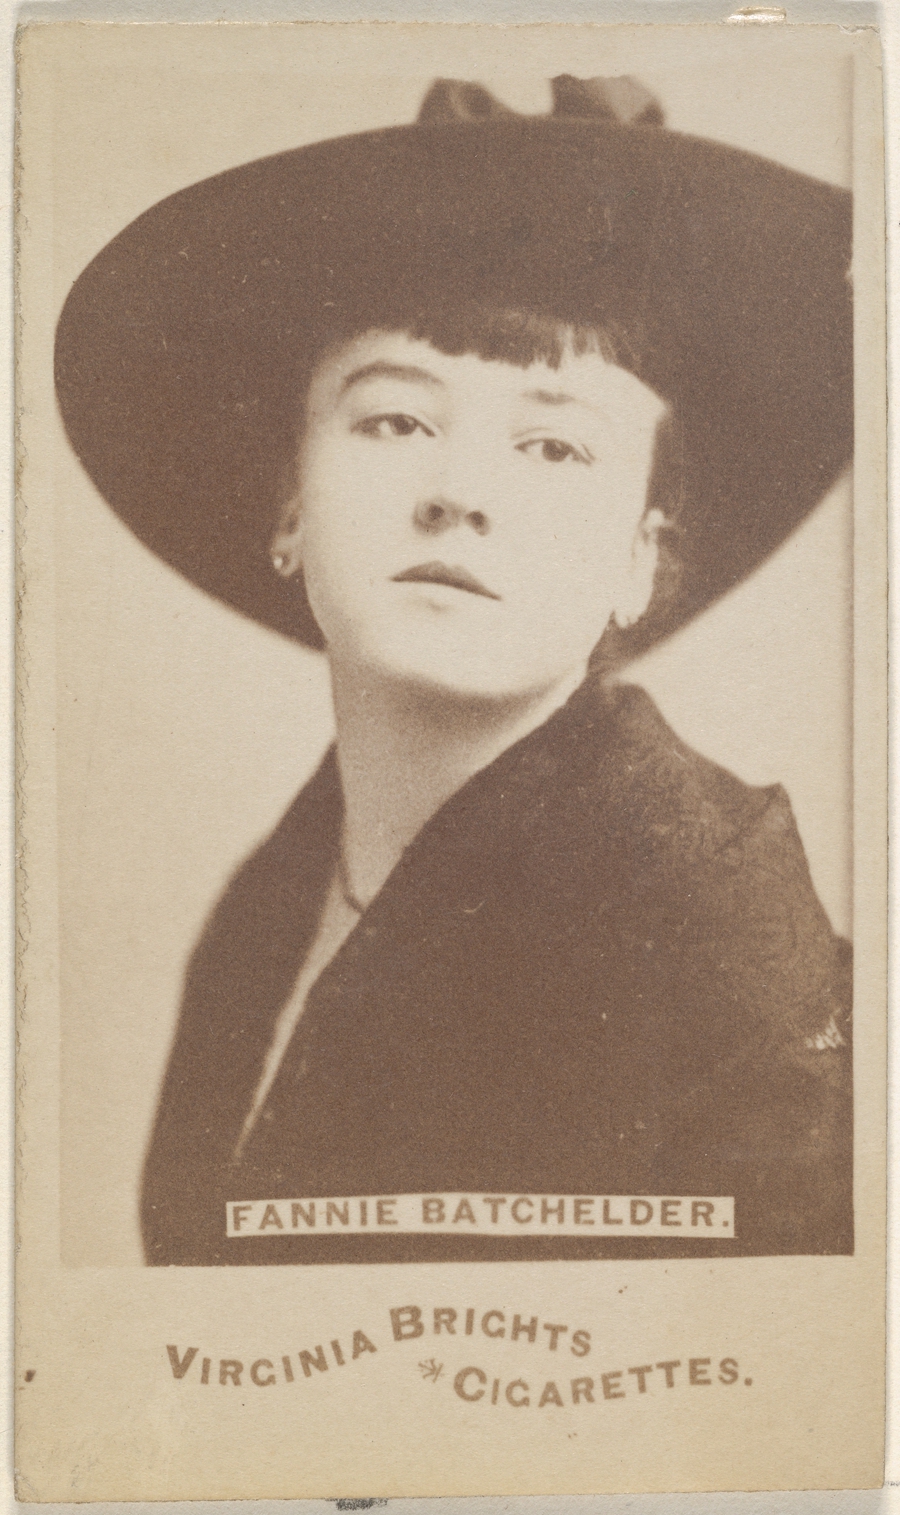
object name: photograph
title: Fannie Batchelder, from the Actors and Actresses series (N45, Type 6) for Virginia Brights Cigarettes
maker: allen & ginter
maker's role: publisher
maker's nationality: american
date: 1888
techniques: albumen silver print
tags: portraits,women,actresses